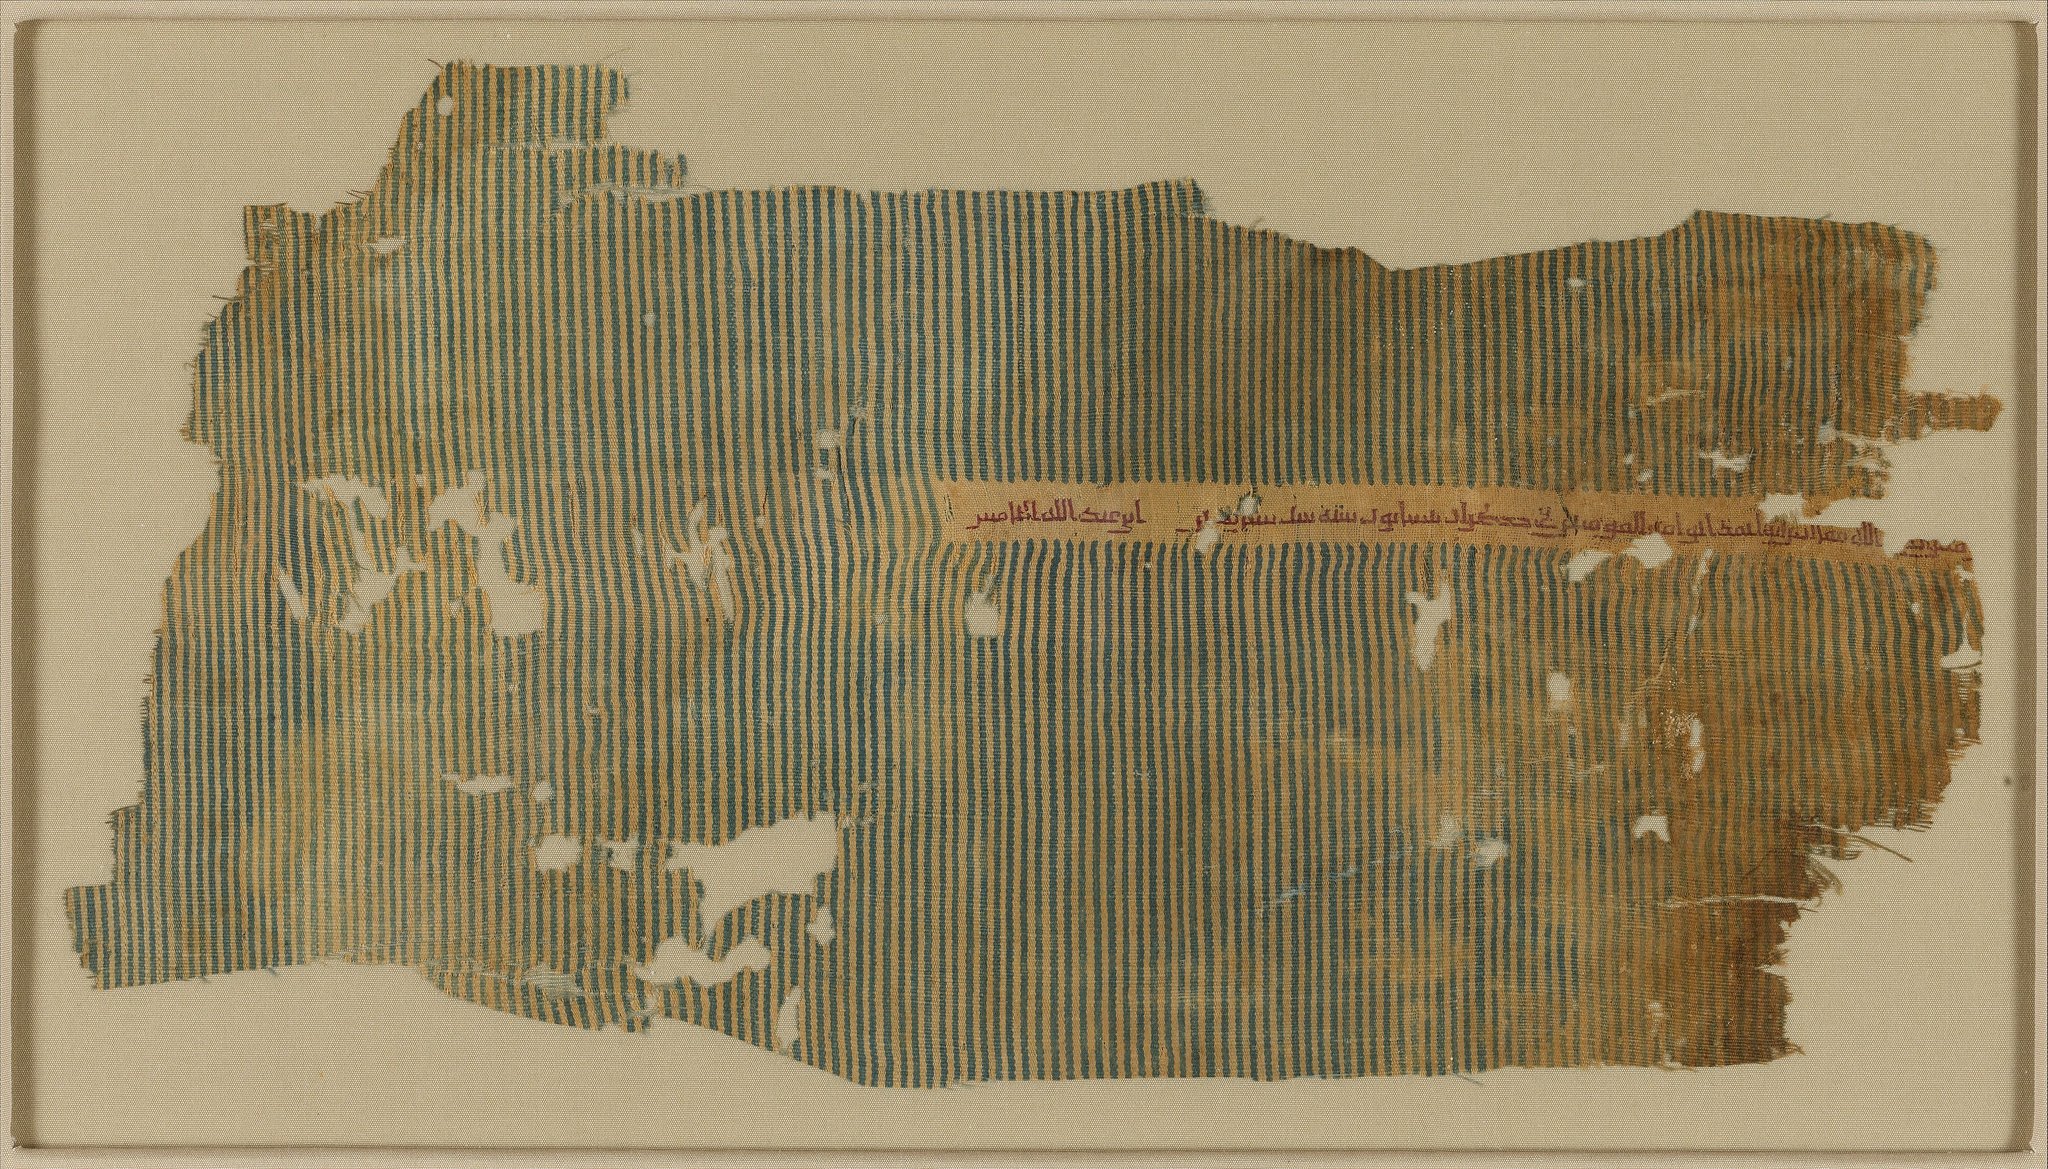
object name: textile fragment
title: Fragment of a Tiraz Textile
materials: silk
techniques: embroidery, weave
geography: iran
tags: arabic